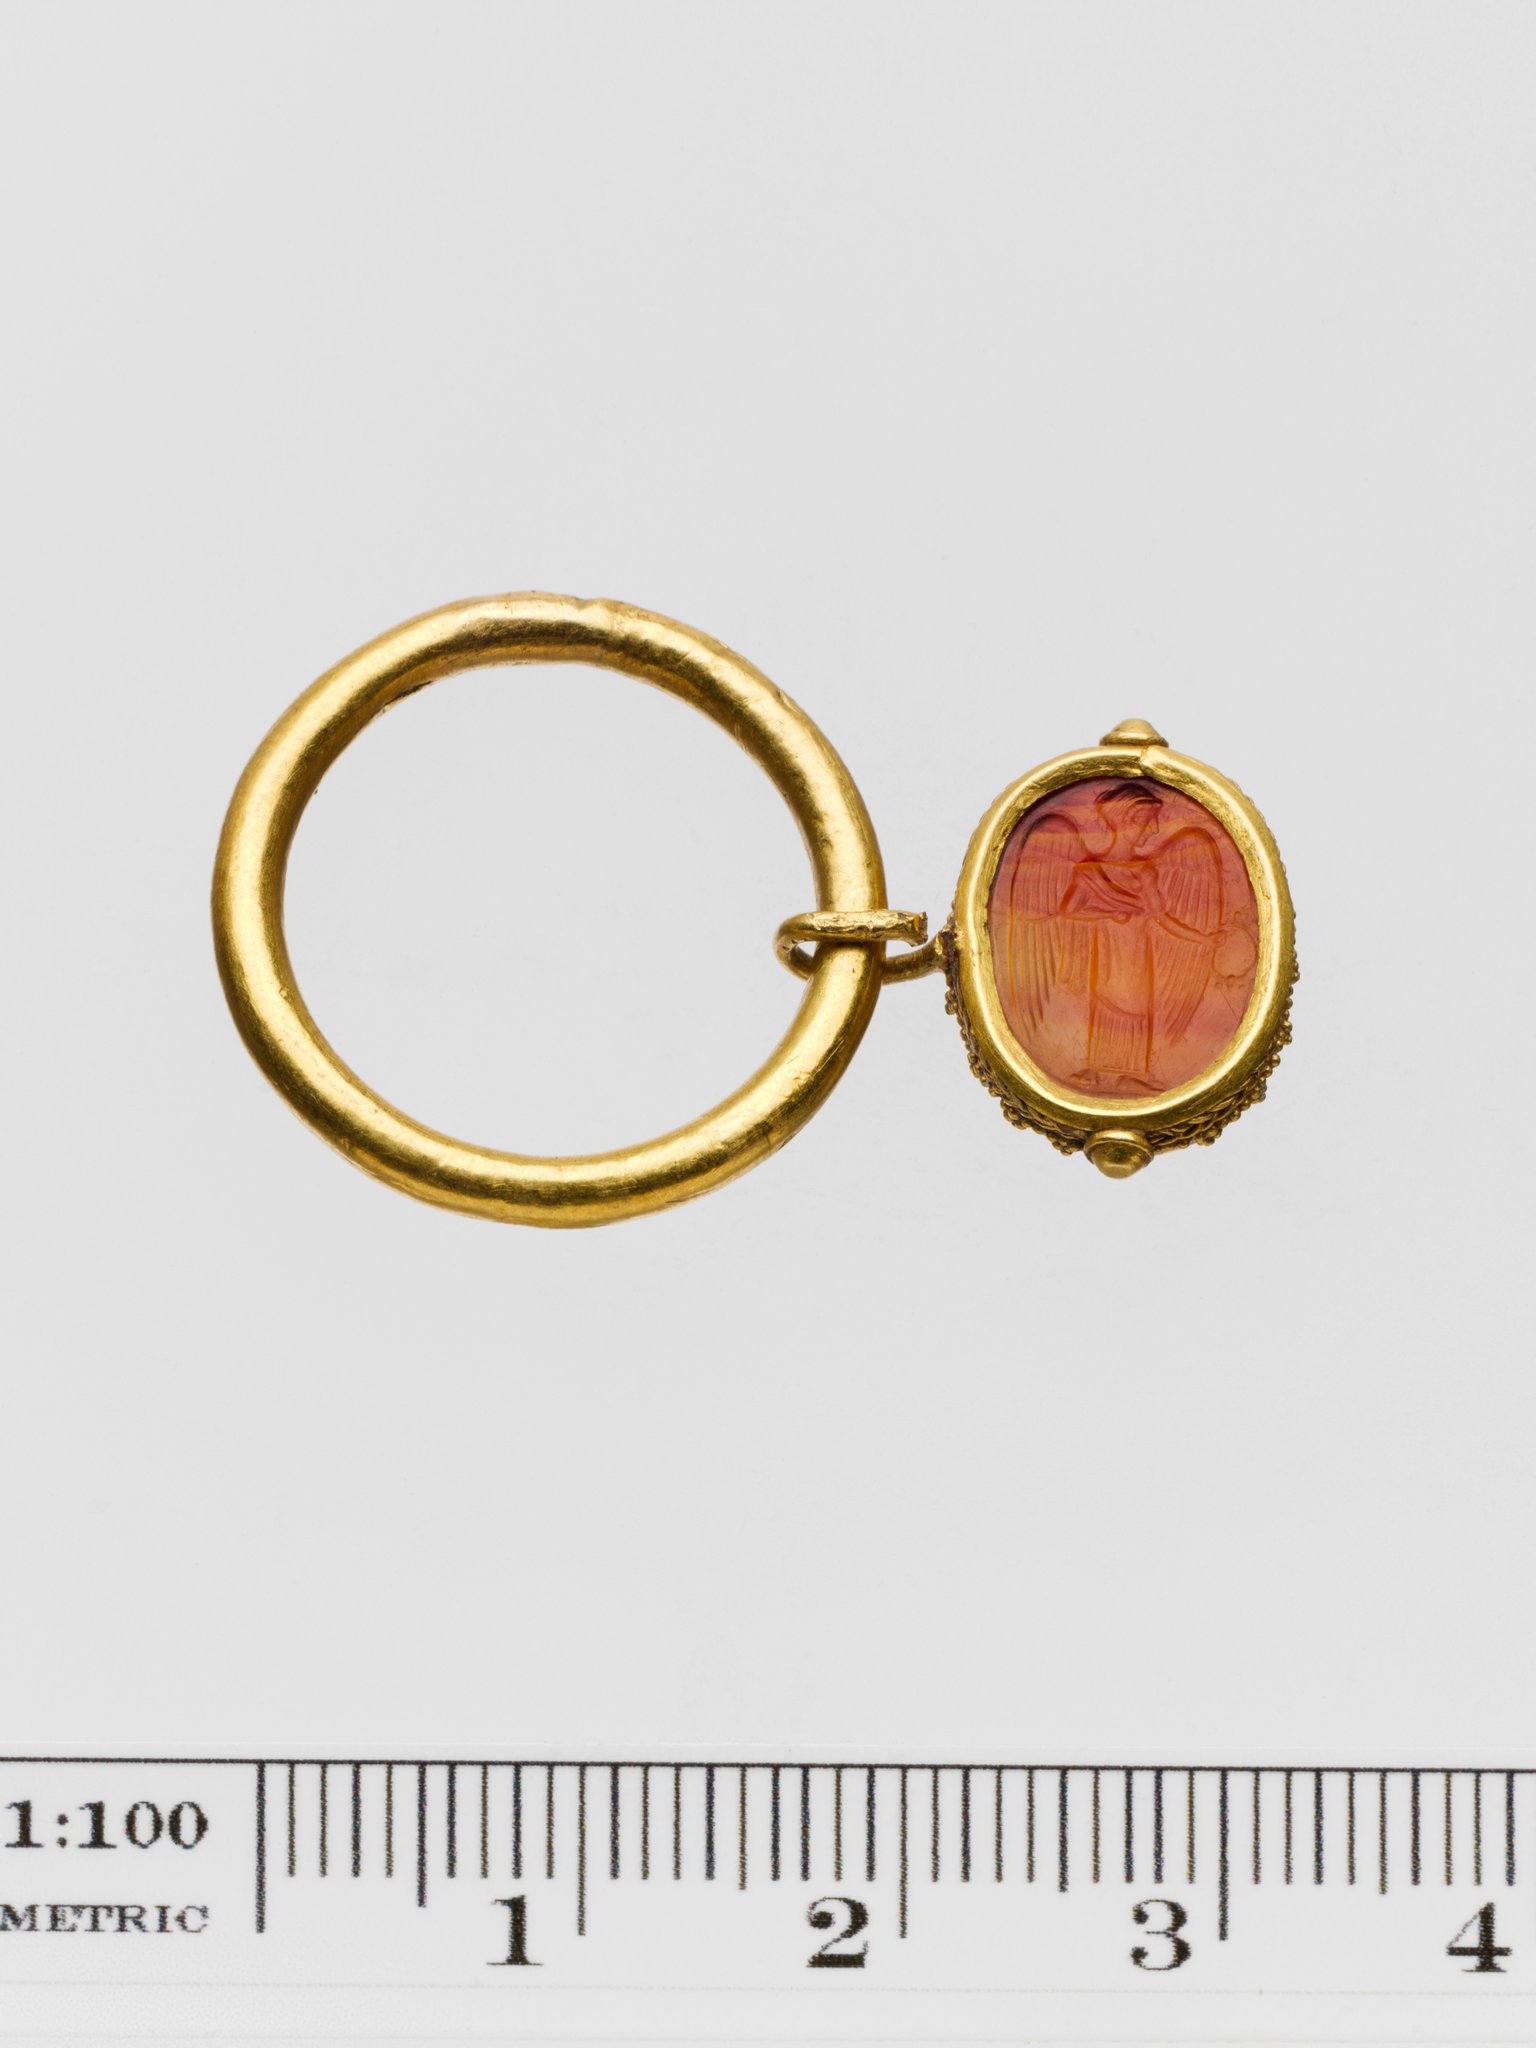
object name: scaraboid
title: Carnelian scaraboid seal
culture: greek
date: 534-468 BCE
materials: gemstone, gold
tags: nike,scarabs,wreaths